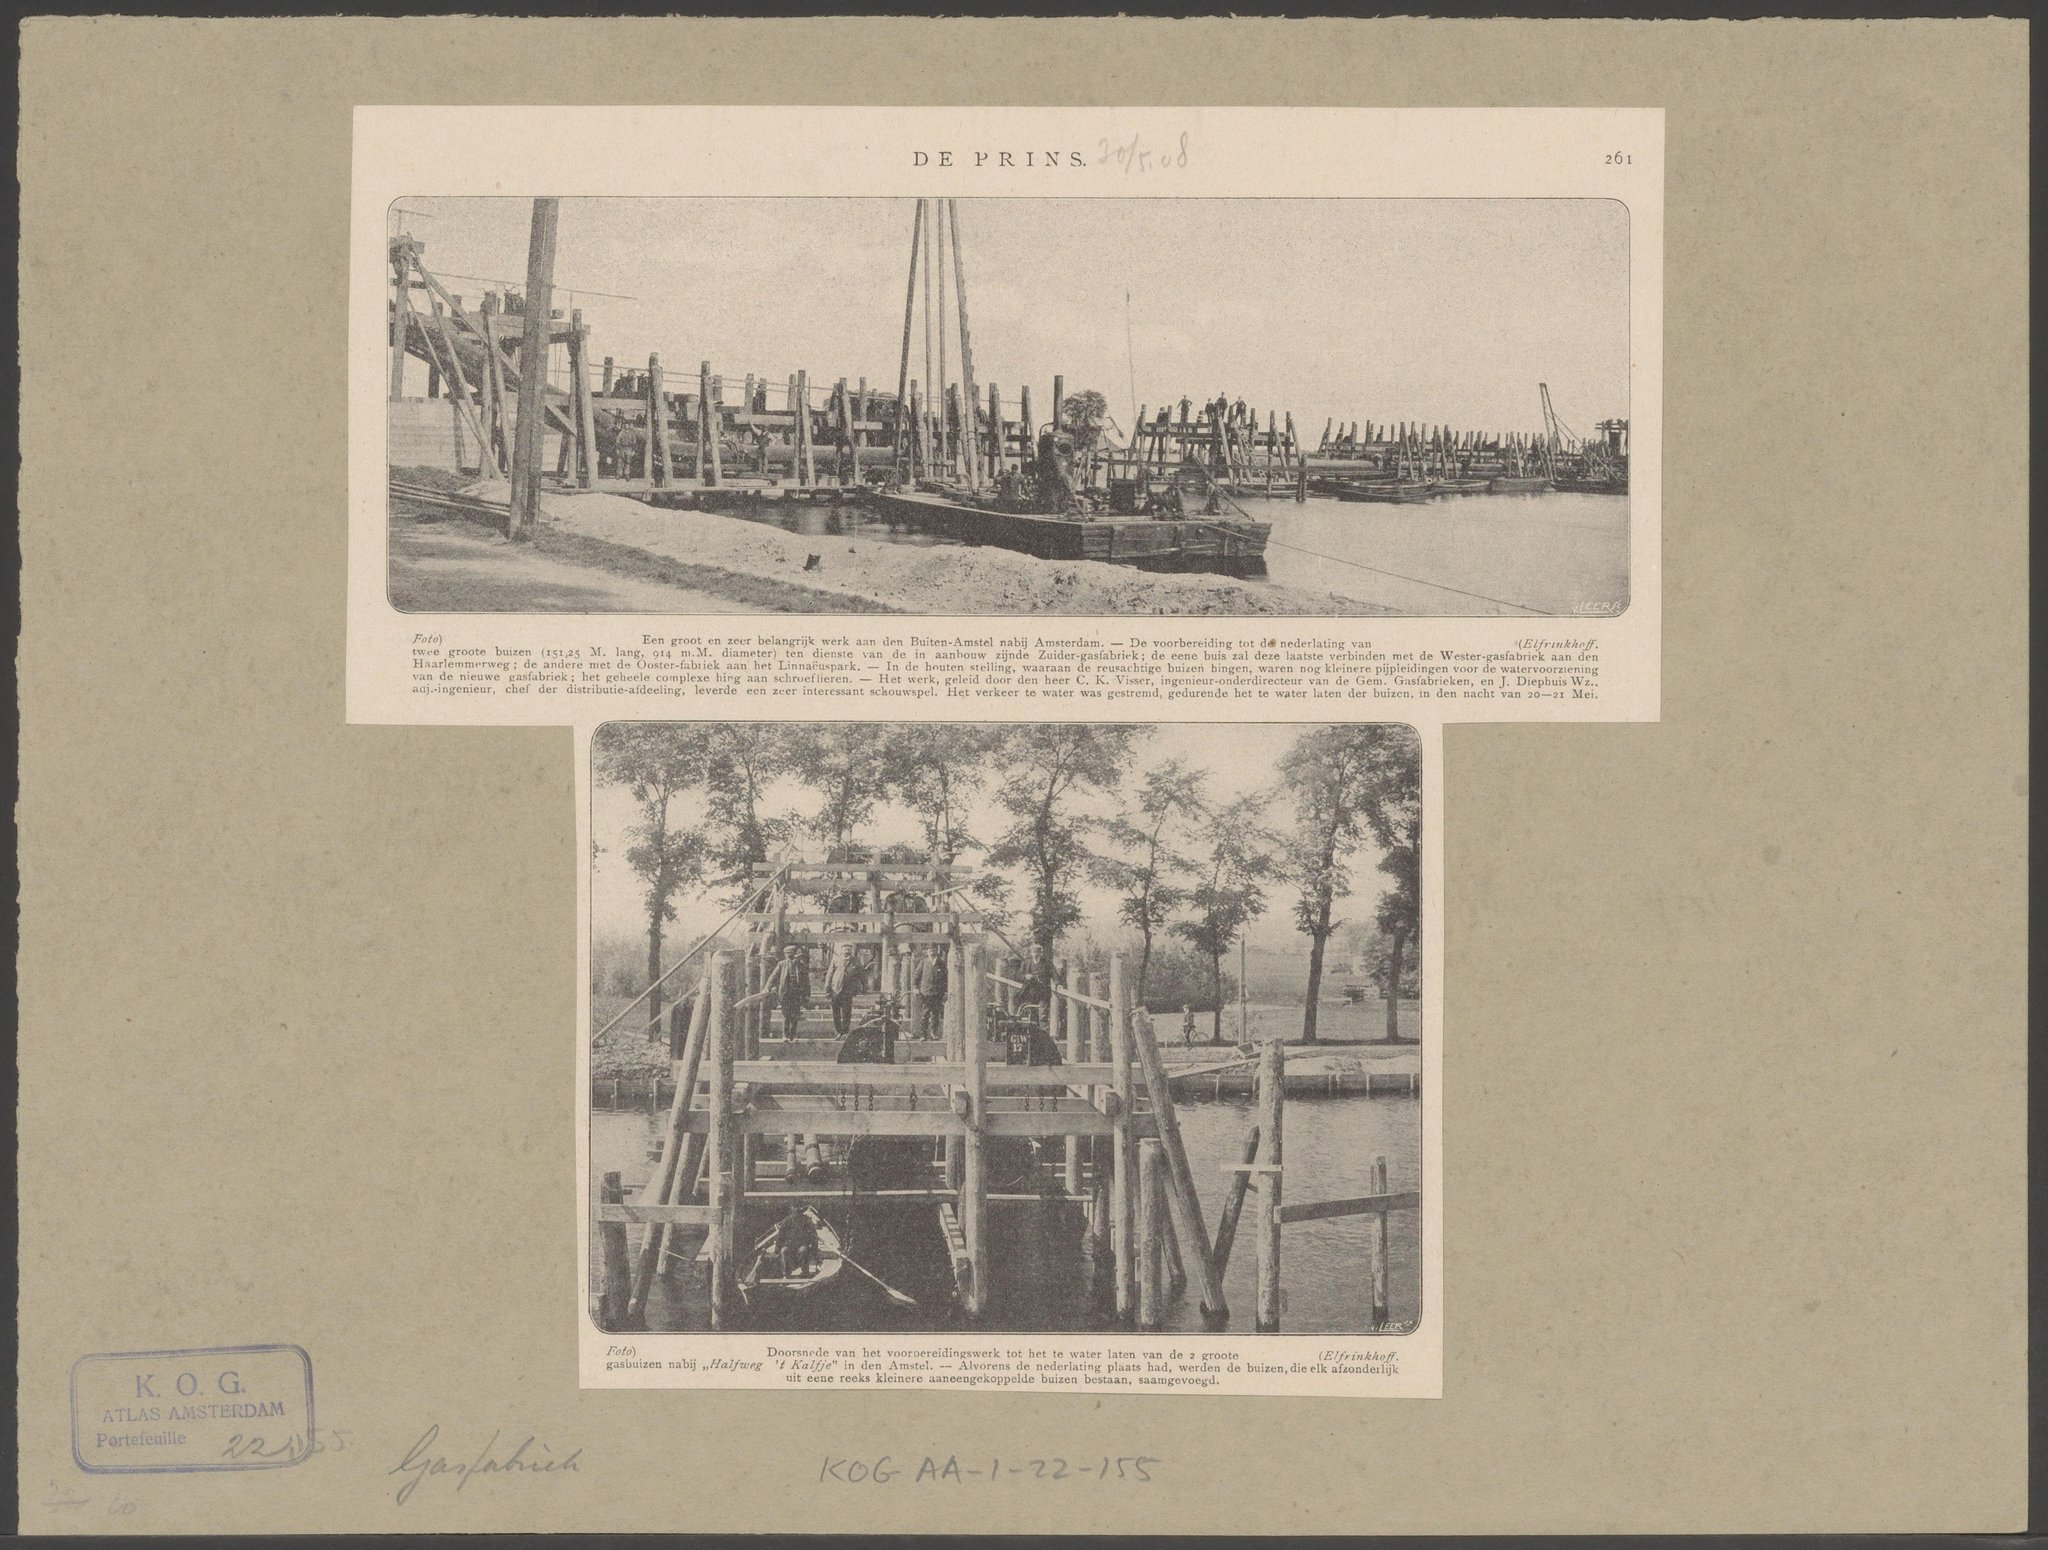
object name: photomechanical print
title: Voorbereidende werken voor het neerlaten van buizen in de Amstel bij de bouw van de Zuidergasfabriek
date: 1908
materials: paper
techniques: letterpress printing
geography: amsterdam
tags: river, making ducts for water, gas and electricity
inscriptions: collector's mark: Lugt 1641b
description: Onderwerpsrubriek binnen de Atlas Amsterdam: Gemeentebedrijven.